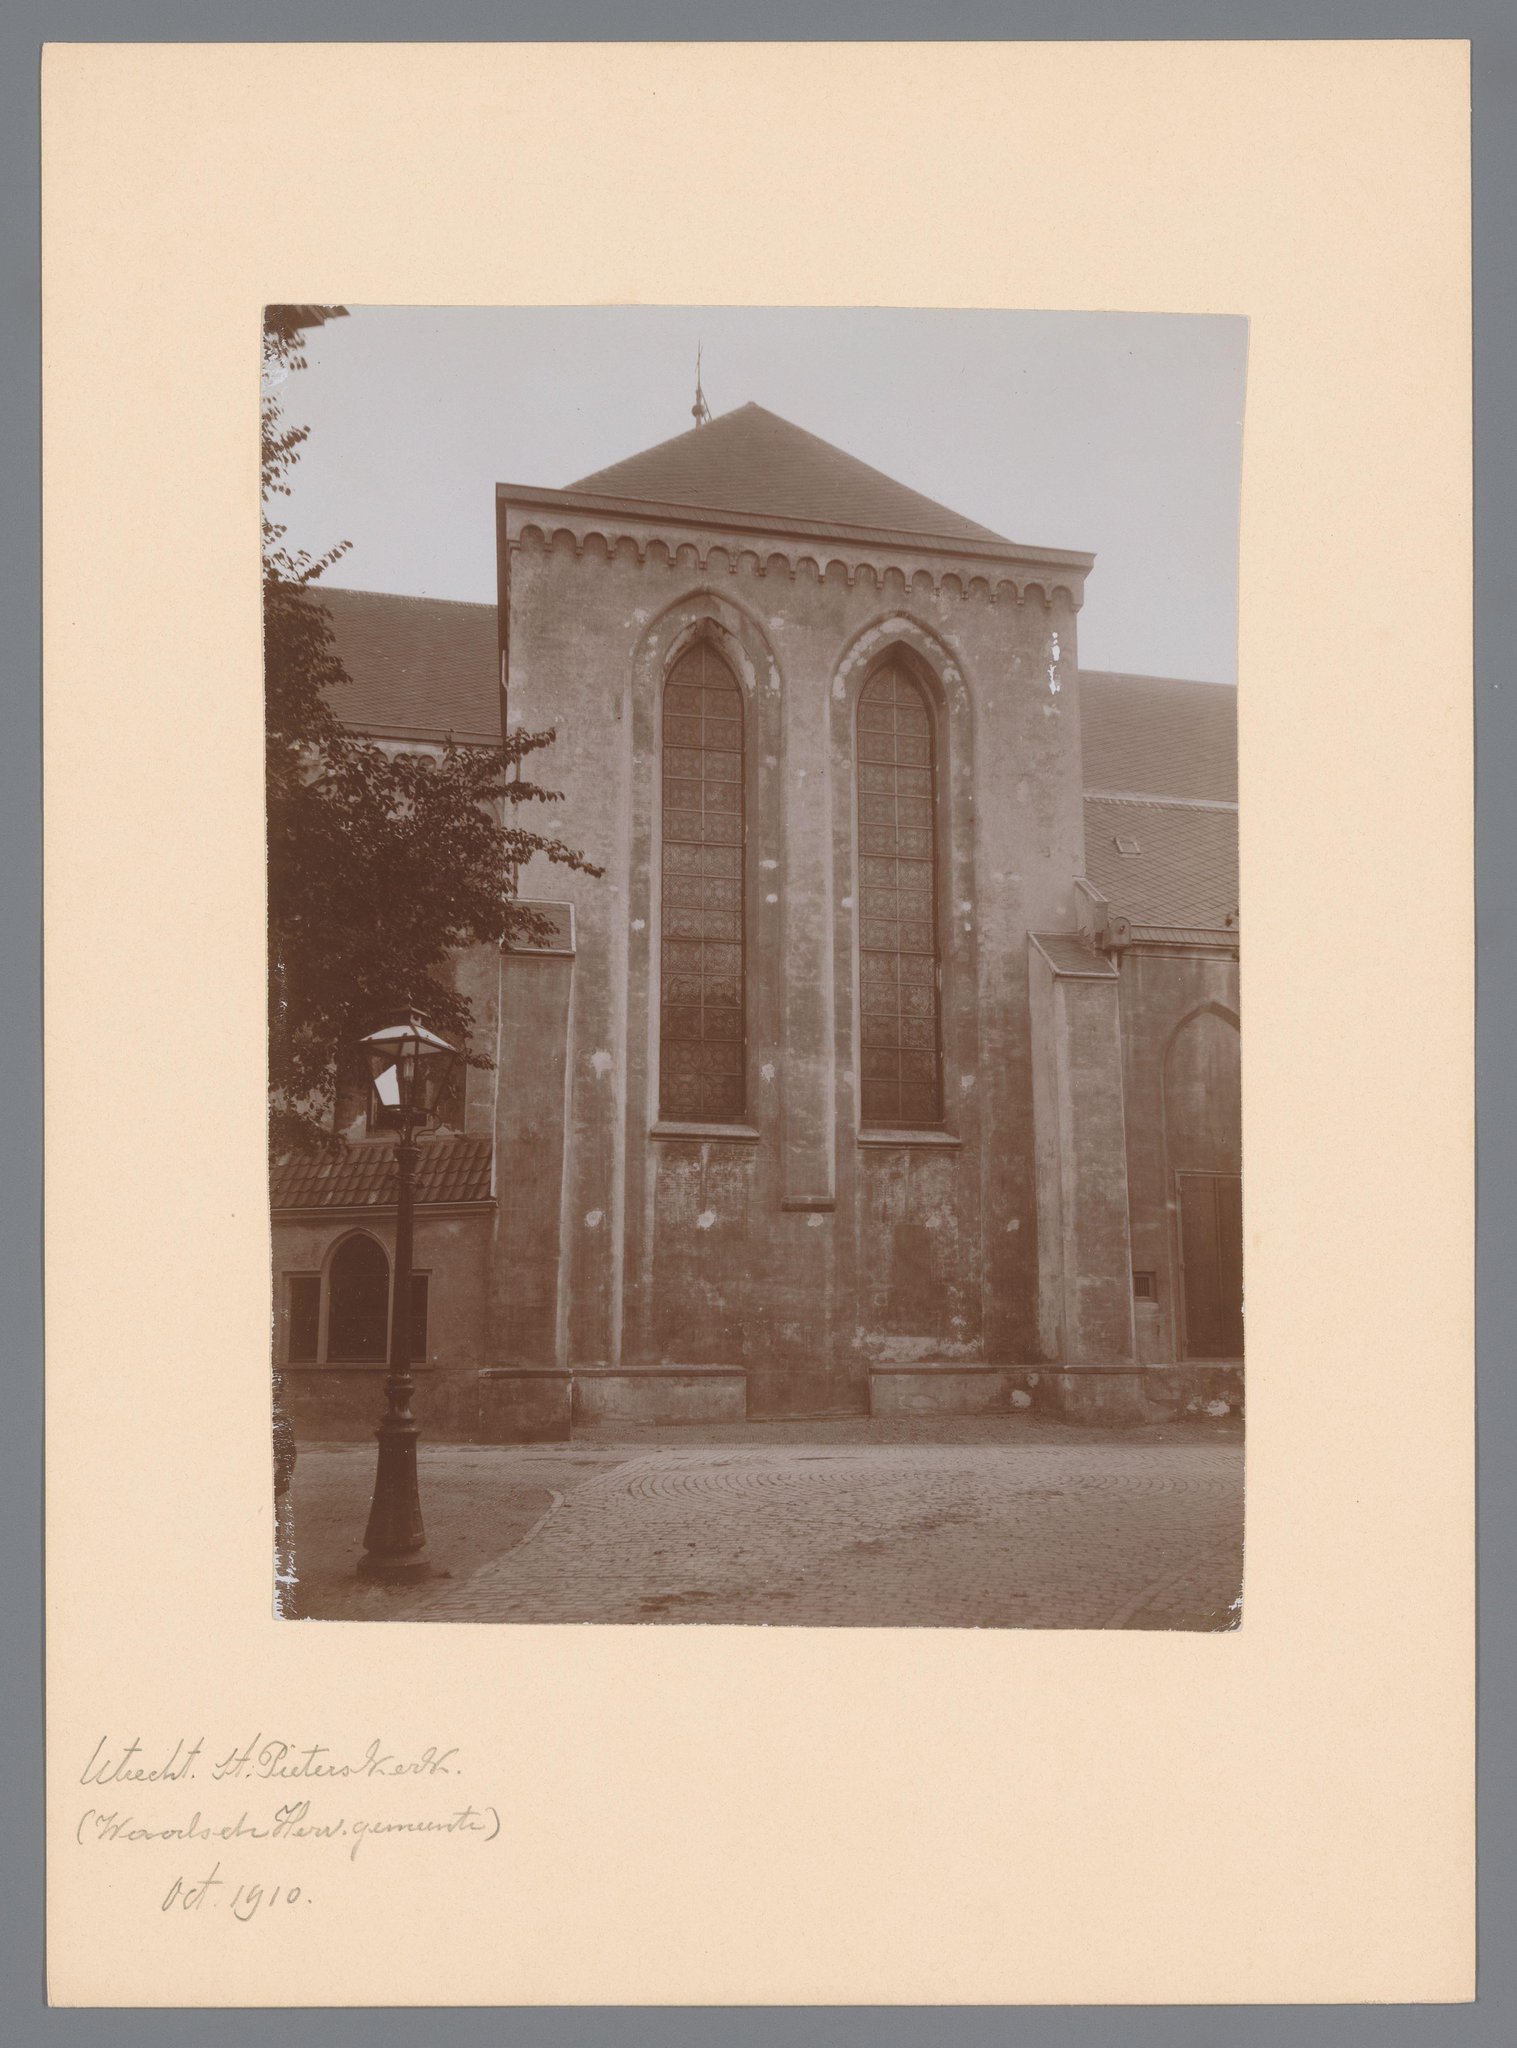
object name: photograph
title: Transept van de Sint-Pieterskerk te Utrecht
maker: anoniem (monumentenzorg)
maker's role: fotograaf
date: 1910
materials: cardboard, photographic support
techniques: collodion silver print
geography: utrecht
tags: parts of church exterior and annexes: transept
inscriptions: annotation: ‘Utrecht St. Pieterskerk/ Waalsch Herv. gemeente/ Oct. 1910’